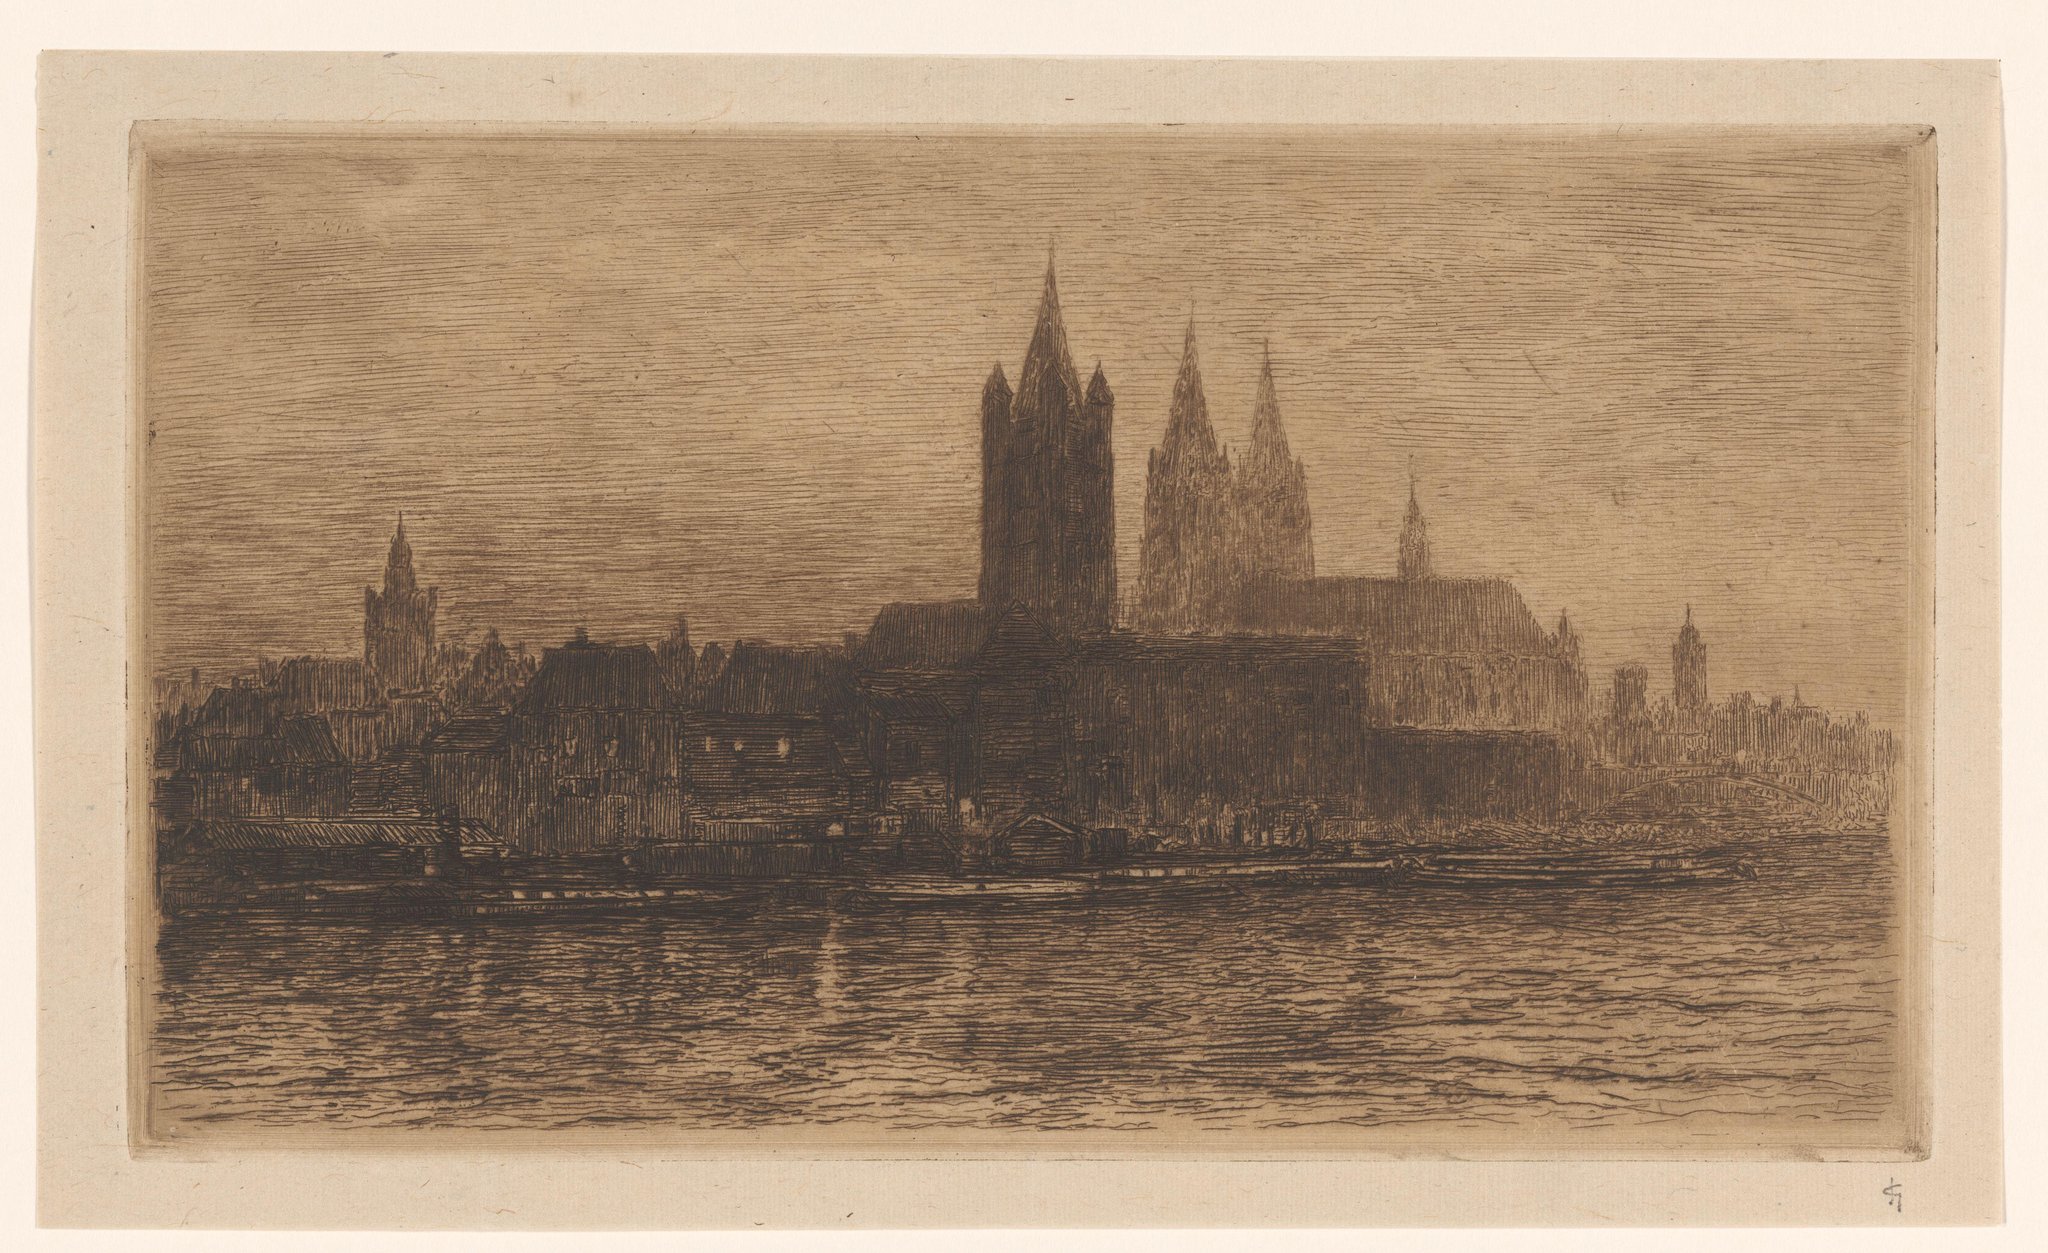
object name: print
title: Gezicht op Keulen bij avond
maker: carel nicolaas storm van s-gravesande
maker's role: draughtsman, print maker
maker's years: 1841-1924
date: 1896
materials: paper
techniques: drypoint, etching, intaglio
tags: evening, church (exterior), prospect of city, town panorama, silhouette of city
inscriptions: collector's mark: Lugt 2228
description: Mogelijk vermeld in: Storm van 's-Gravesande, Charles. Catalogue des eaux-fortes et lithographies. New York: s.n., 1903, of in een onbekende latere uitgave van het manuscript. Vermoedelijk vermeld als catalogusnummer 387.